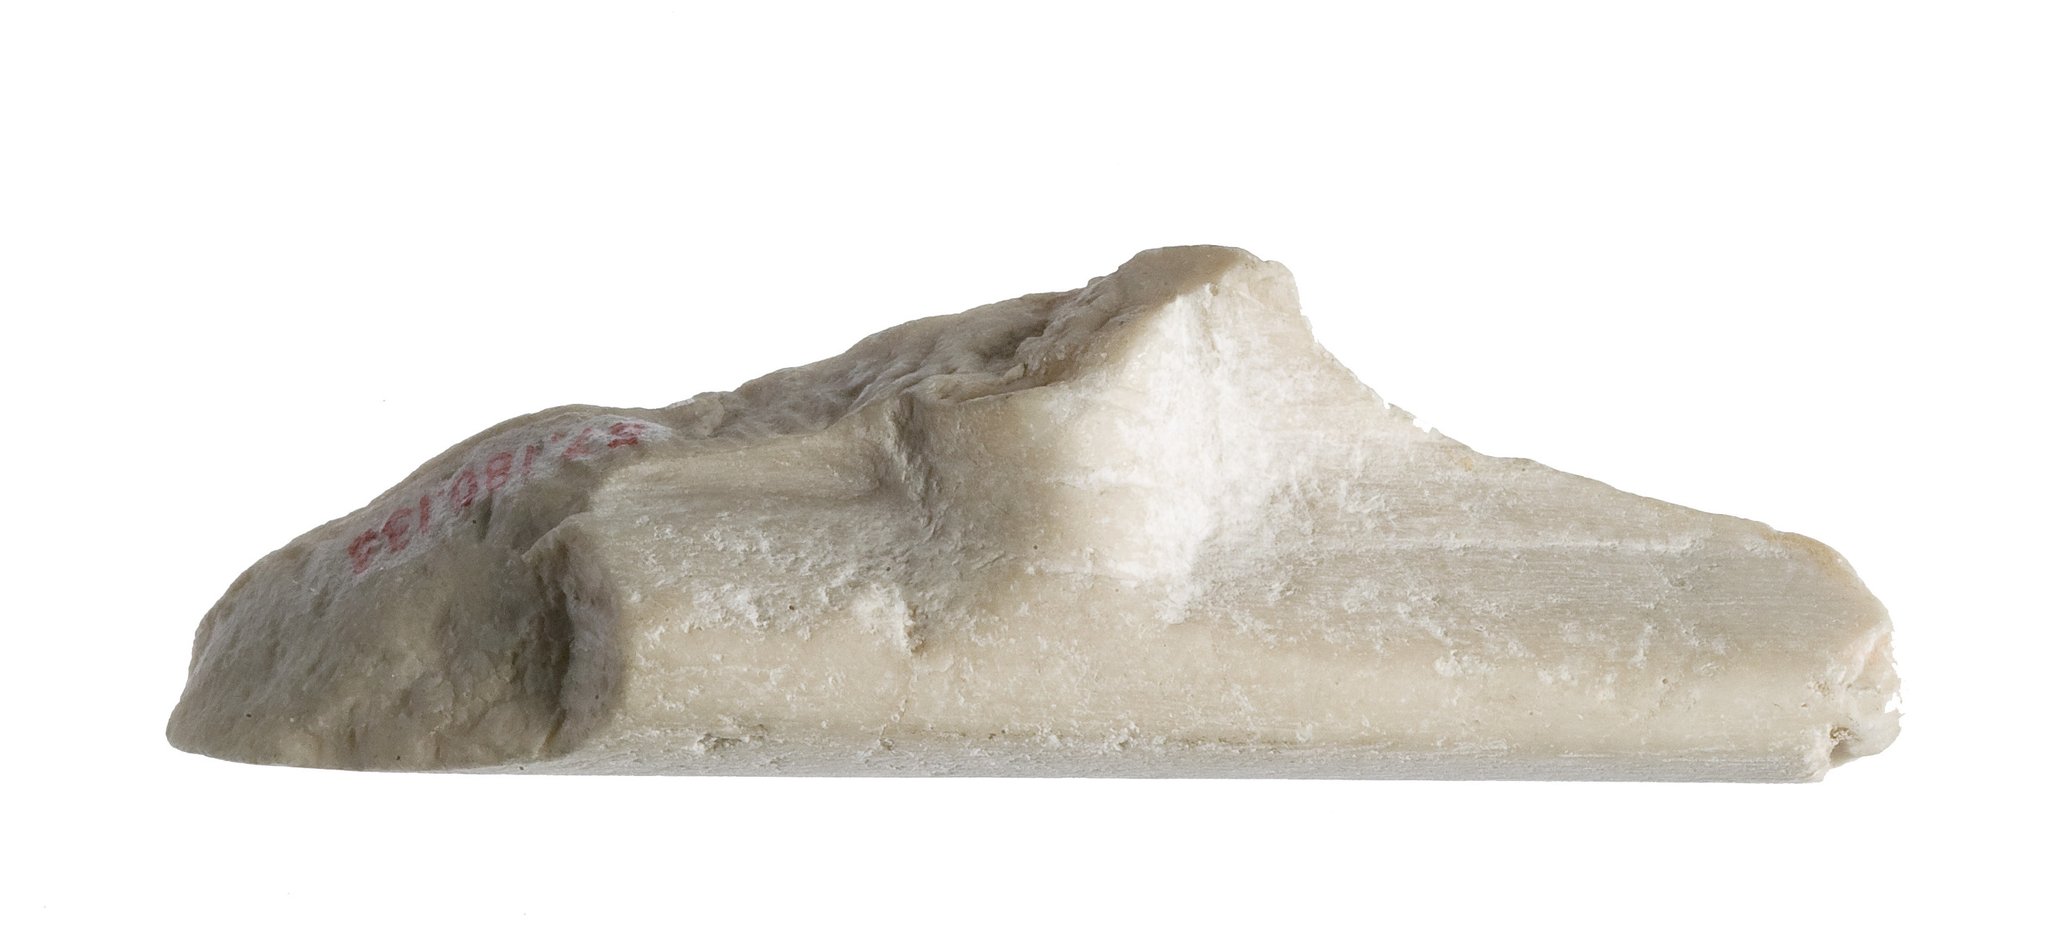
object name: fragment, unknown element, high relief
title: Fragment with unknown elements in high relief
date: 1353-1336 BCE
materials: limestone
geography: egypt